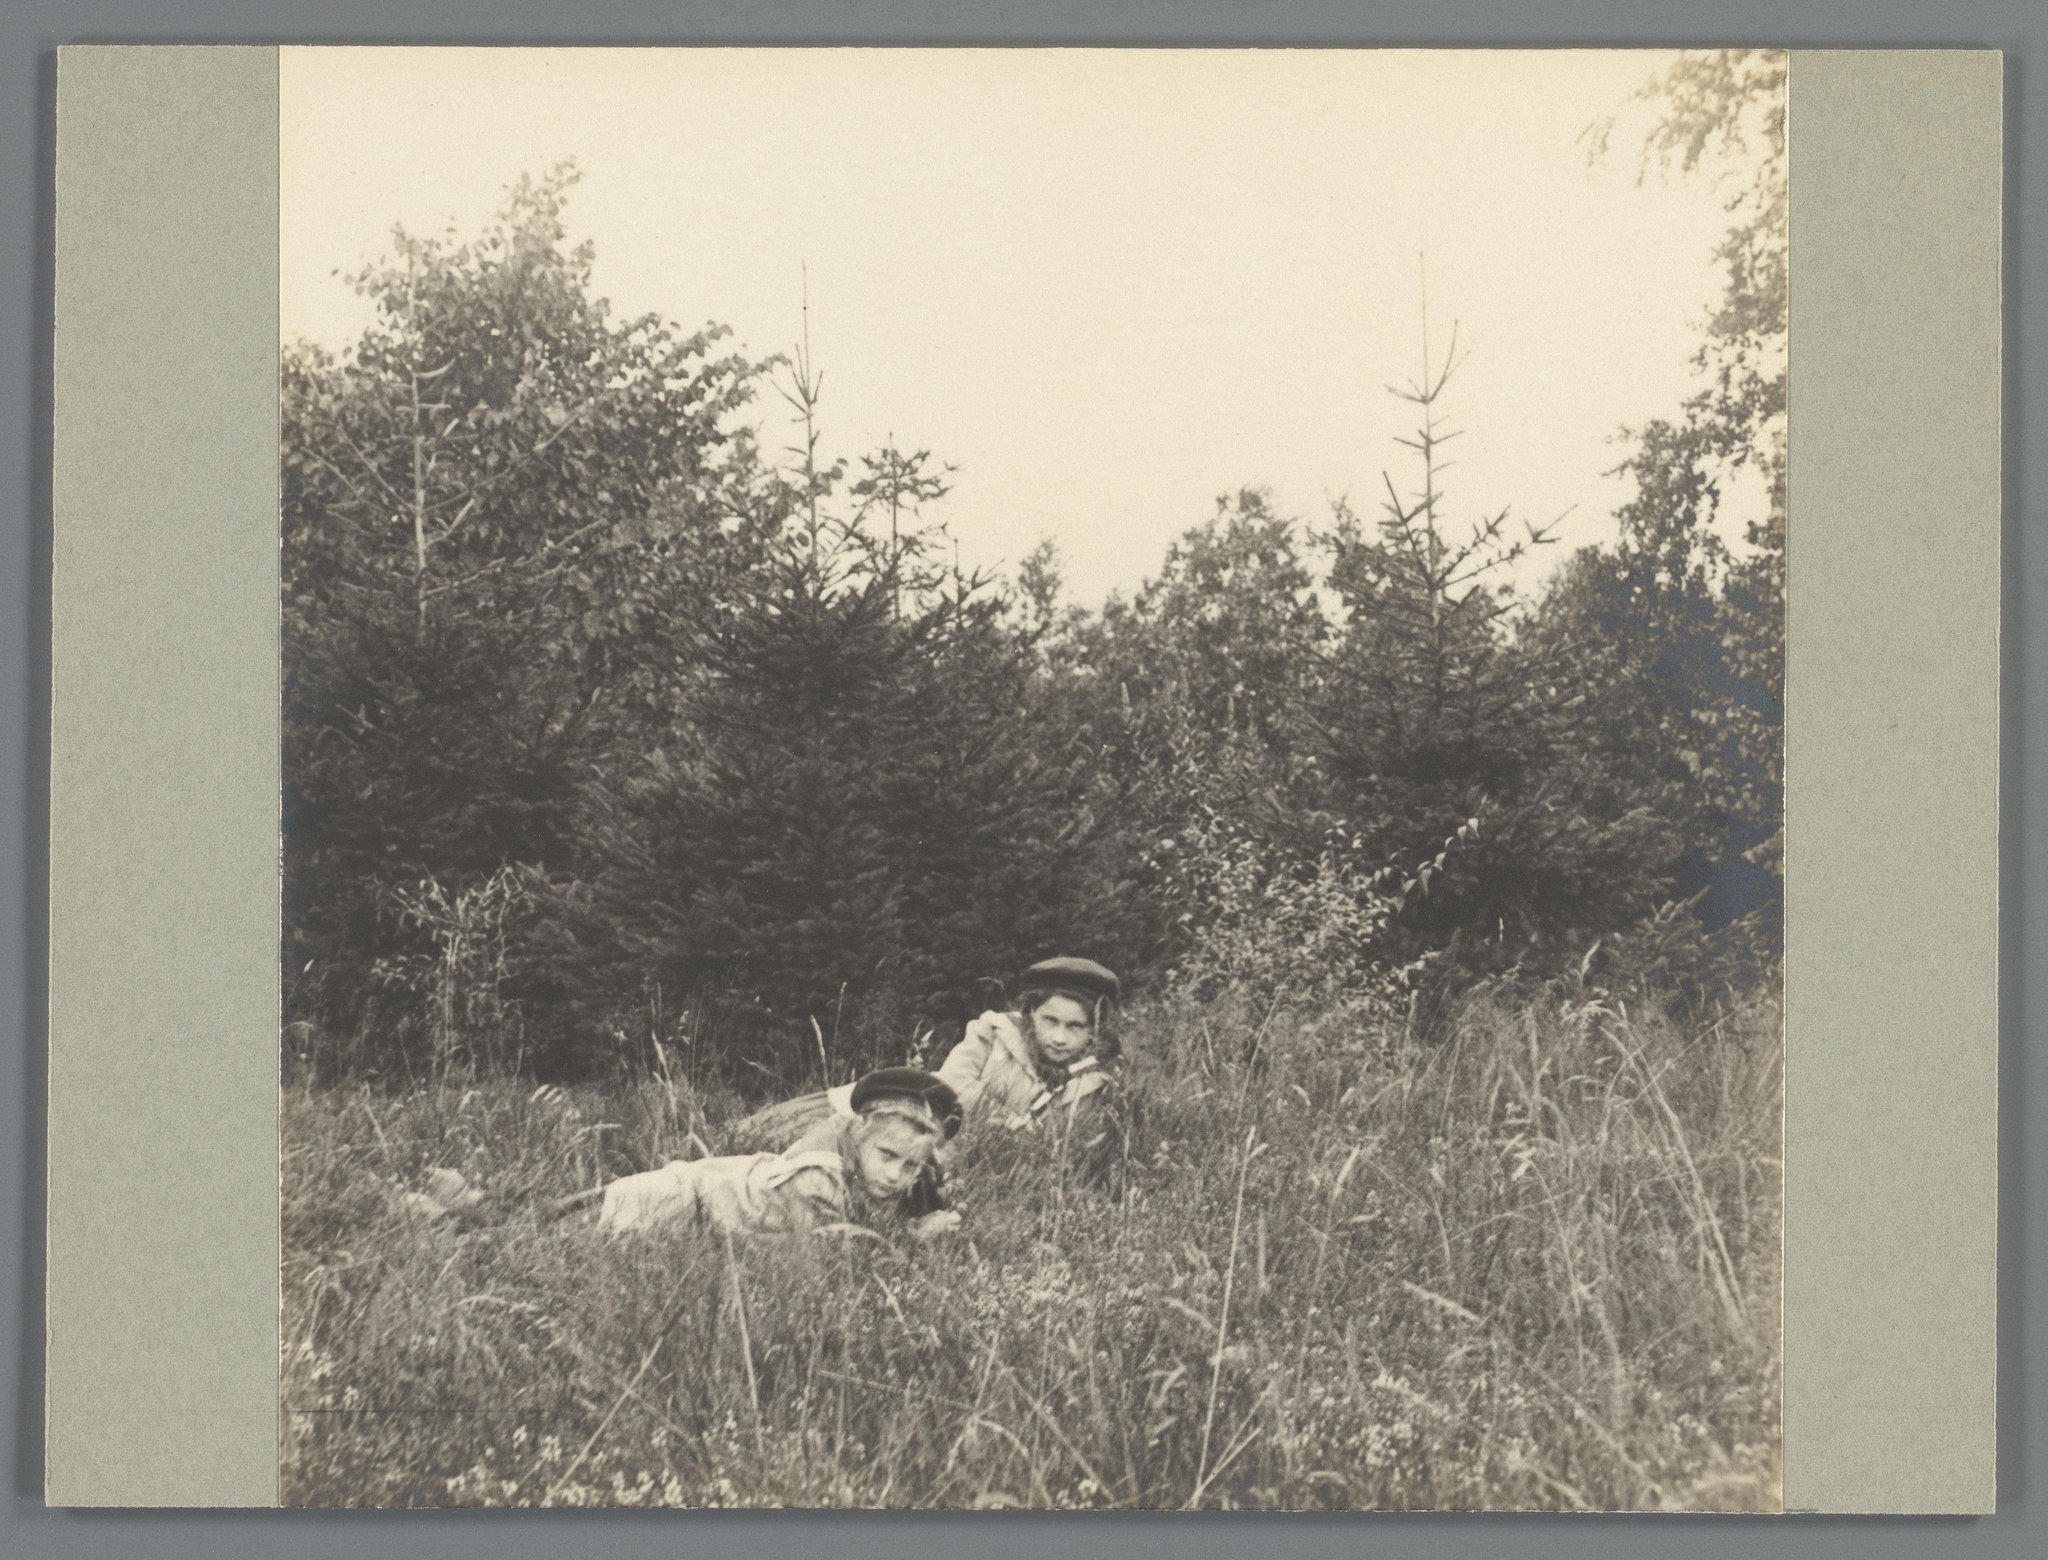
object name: photograph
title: Johanna (Hans) de Jong en Johanna (Nan) Vreede liggend in een weiland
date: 1905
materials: paper, cardboard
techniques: gelatin silver print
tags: leiden, johanna petronella lambertina stokhuyzen-de jong (hans), johanna elisabeth borgerhoff mulder-vreede (nan), child, meadow, pasture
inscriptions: date: ‘ca 1905’, name: ‘Johanna P. L. de Jong en/ Johanna Elisabeth Vreede.’